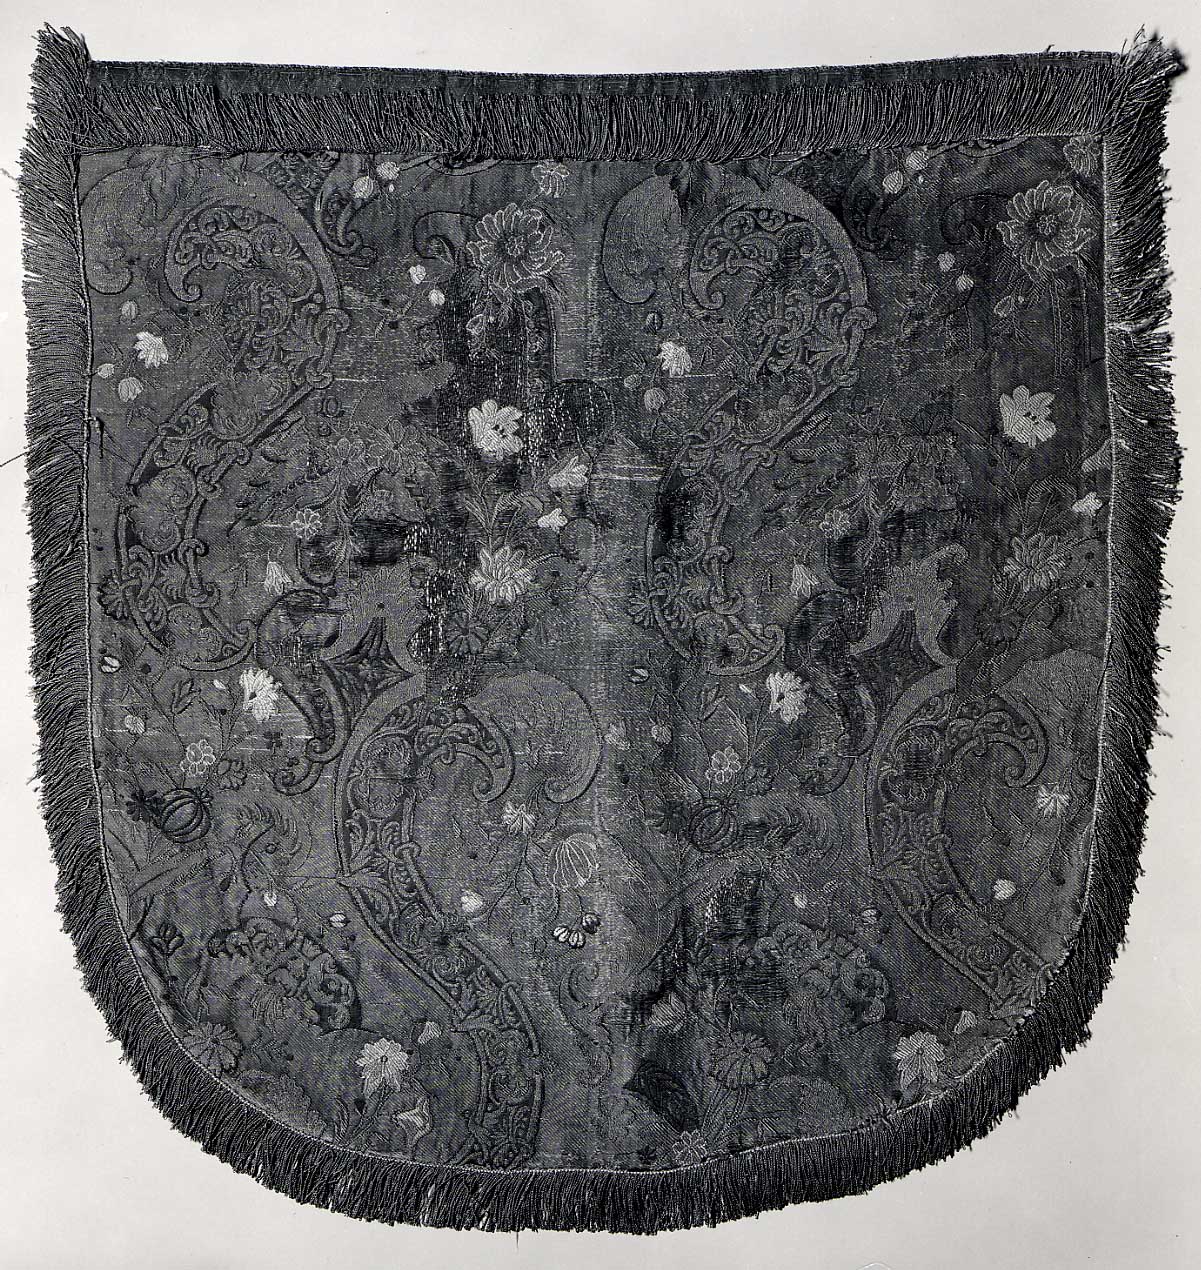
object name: hood from a cope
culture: french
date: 1701-1800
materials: linen, metal, silk